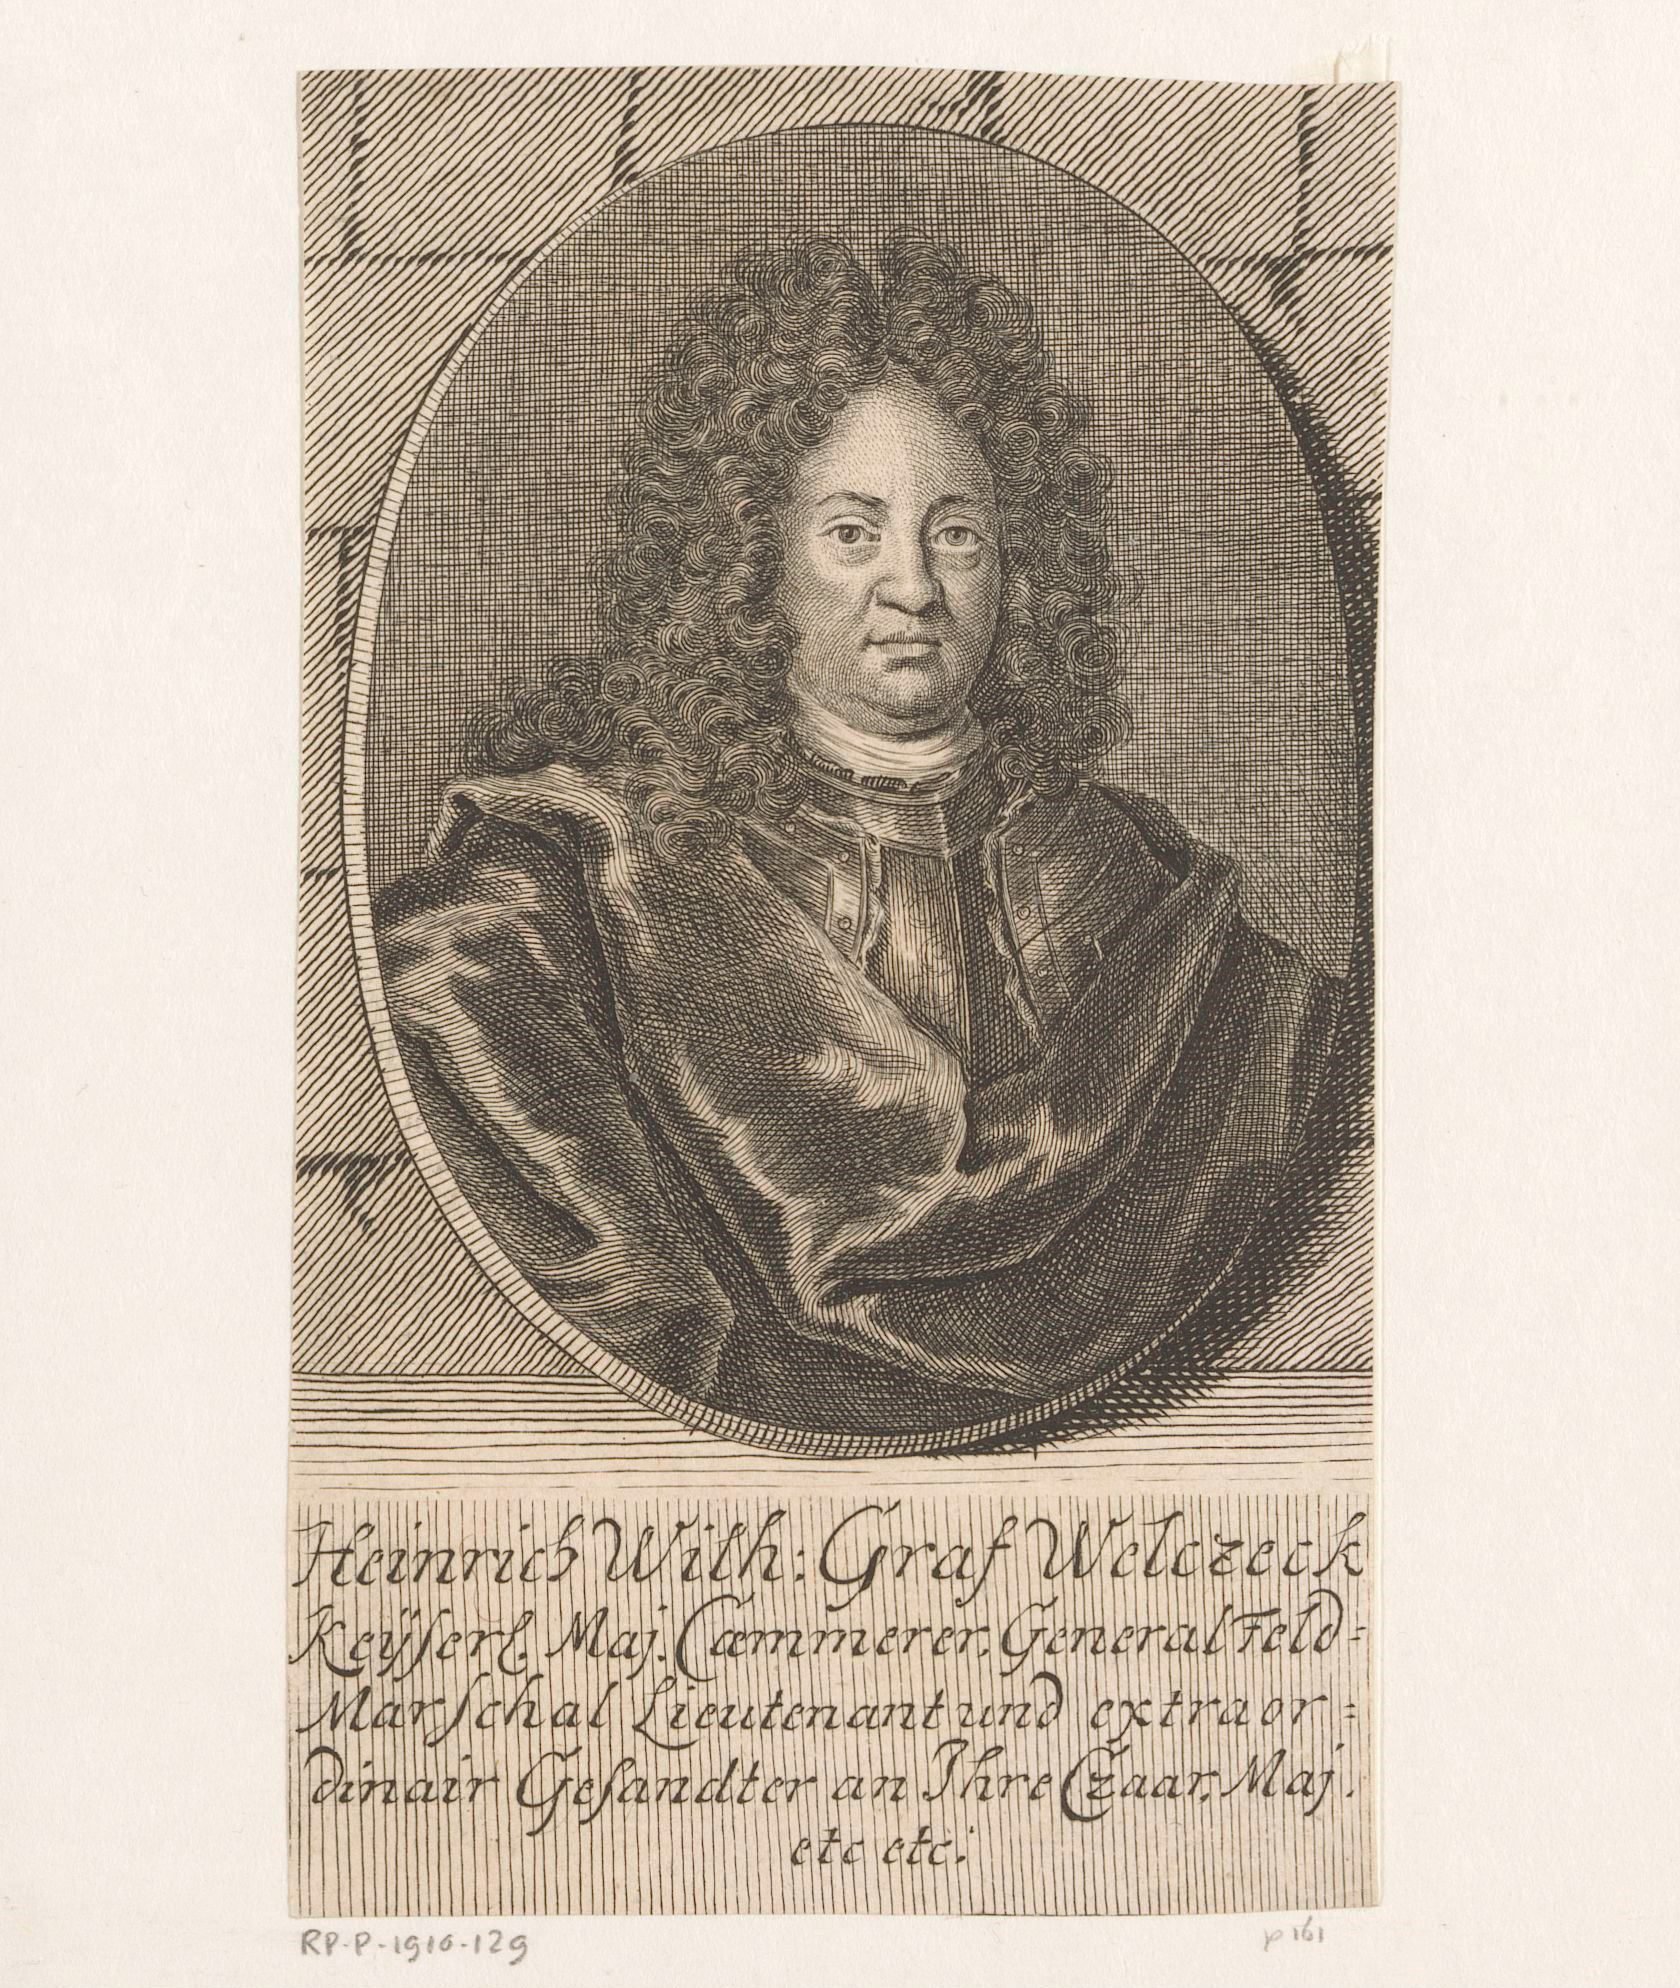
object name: print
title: Portret van Heinrich Wilhelm graaf van Wilczek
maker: martin bernigeroth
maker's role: print maker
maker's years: 1670-1733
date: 1710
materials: paper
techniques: engraving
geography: leipzig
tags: armour, historical persons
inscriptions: collector's mark: Lugt 2228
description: Prent waarschijnlijk uit: Die Europäische Fama, nr. 106, 1710.